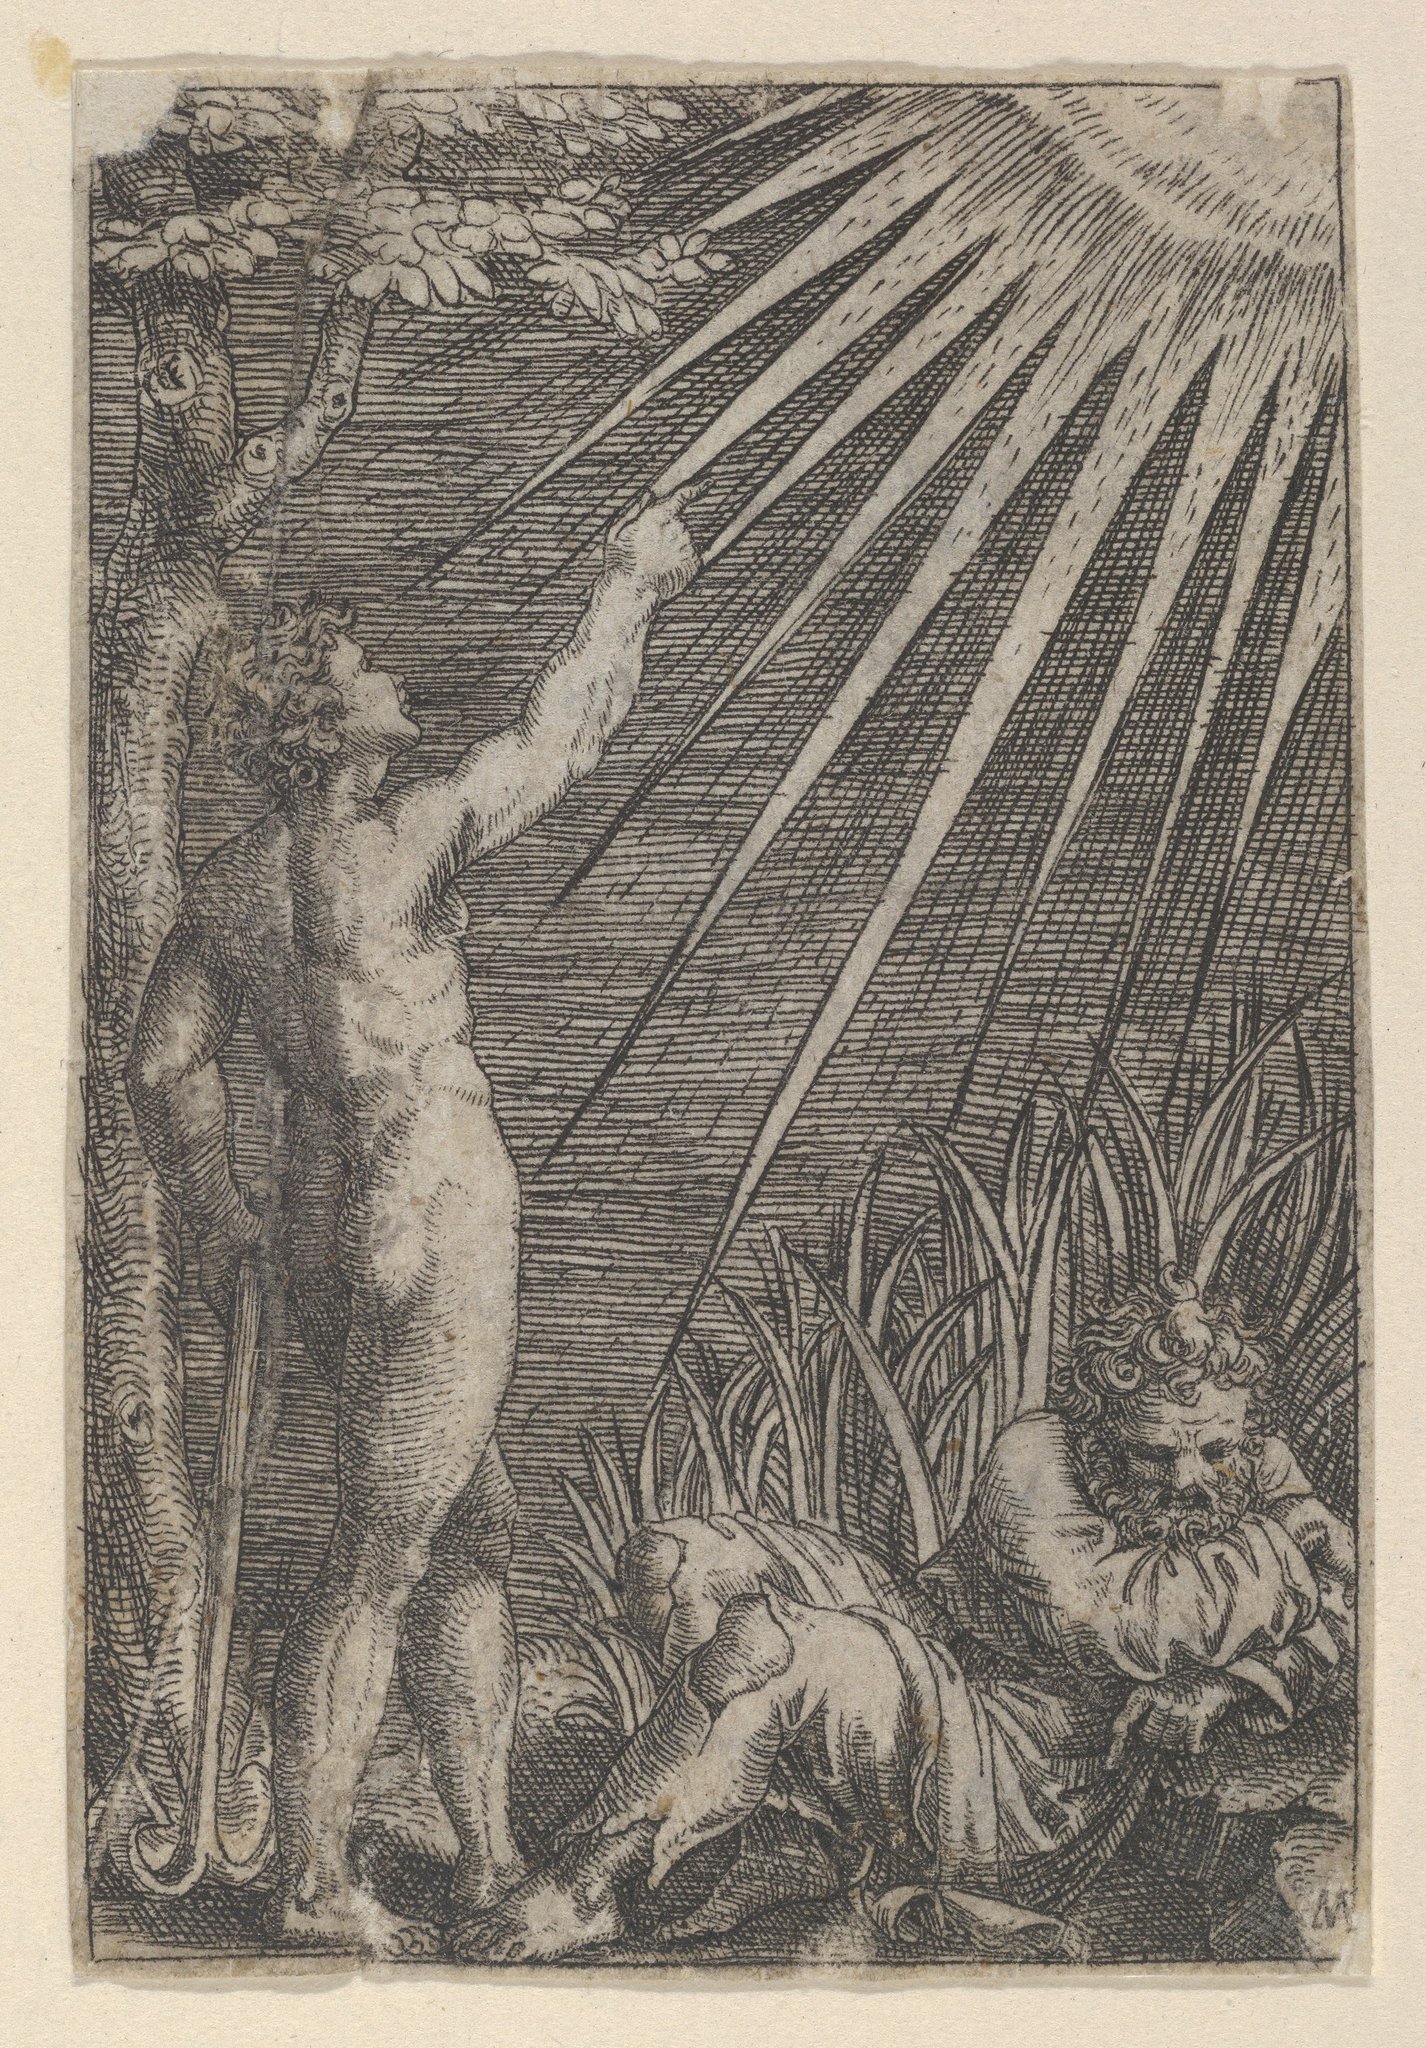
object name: print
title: An old man reclining on the ground at right; at left a naked younger man standing pointing toward the sun with and leaning on an anchor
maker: marcantonio raimondi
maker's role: artist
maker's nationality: italian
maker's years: 1475-1534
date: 1510-1527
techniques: engraving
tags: men,male nudes,sun,trees